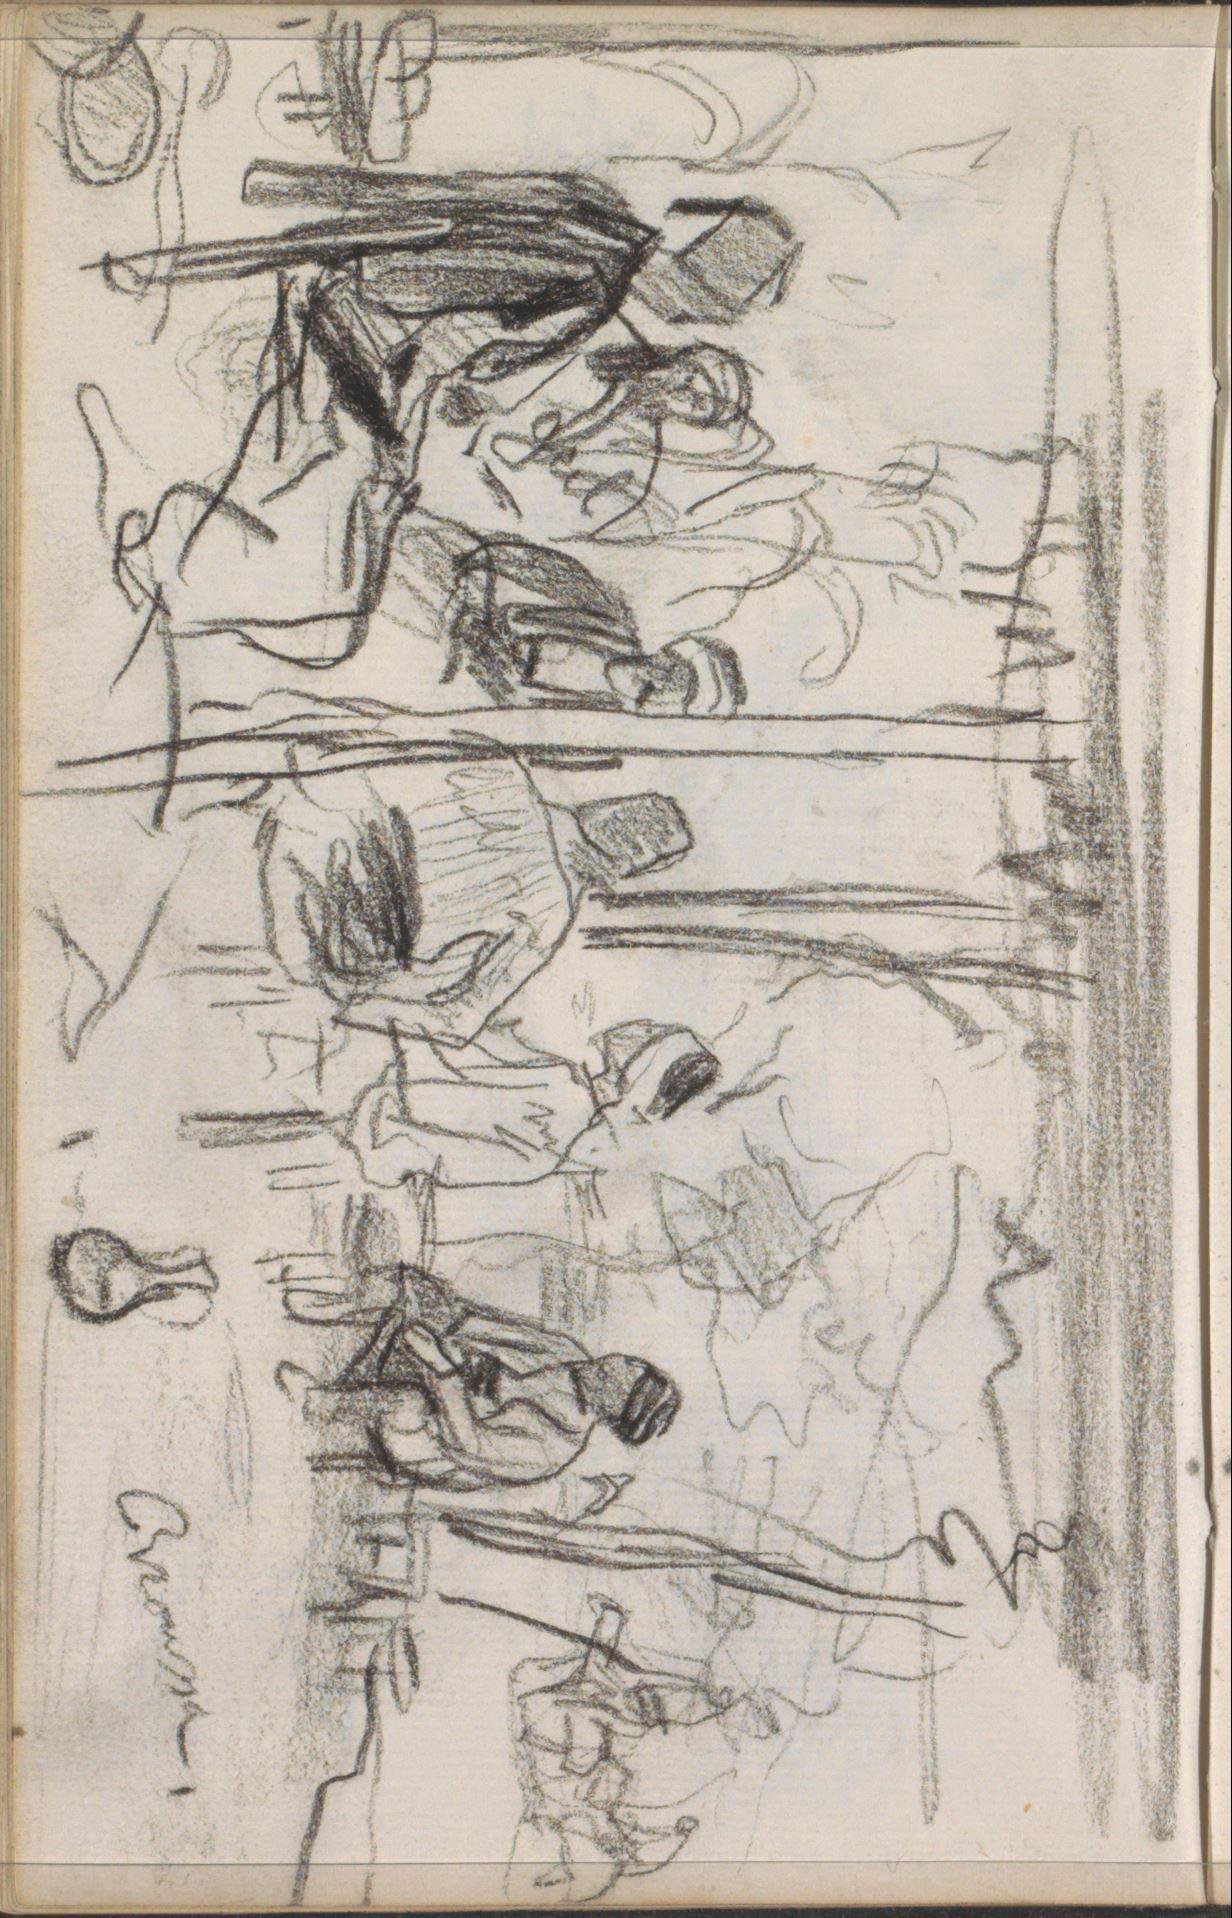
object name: sketchbook leaf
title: Turkse mannen in Broussa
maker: marius bauer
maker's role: draughtsman, print maker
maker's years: 1867-1932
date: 1899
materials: chalk, paper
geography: broussa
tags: asiatic races and peoples, sitting figure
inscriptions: annotation: ‘Broussa’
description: Pagina 12 uit een schetsboek met 42 bladen.